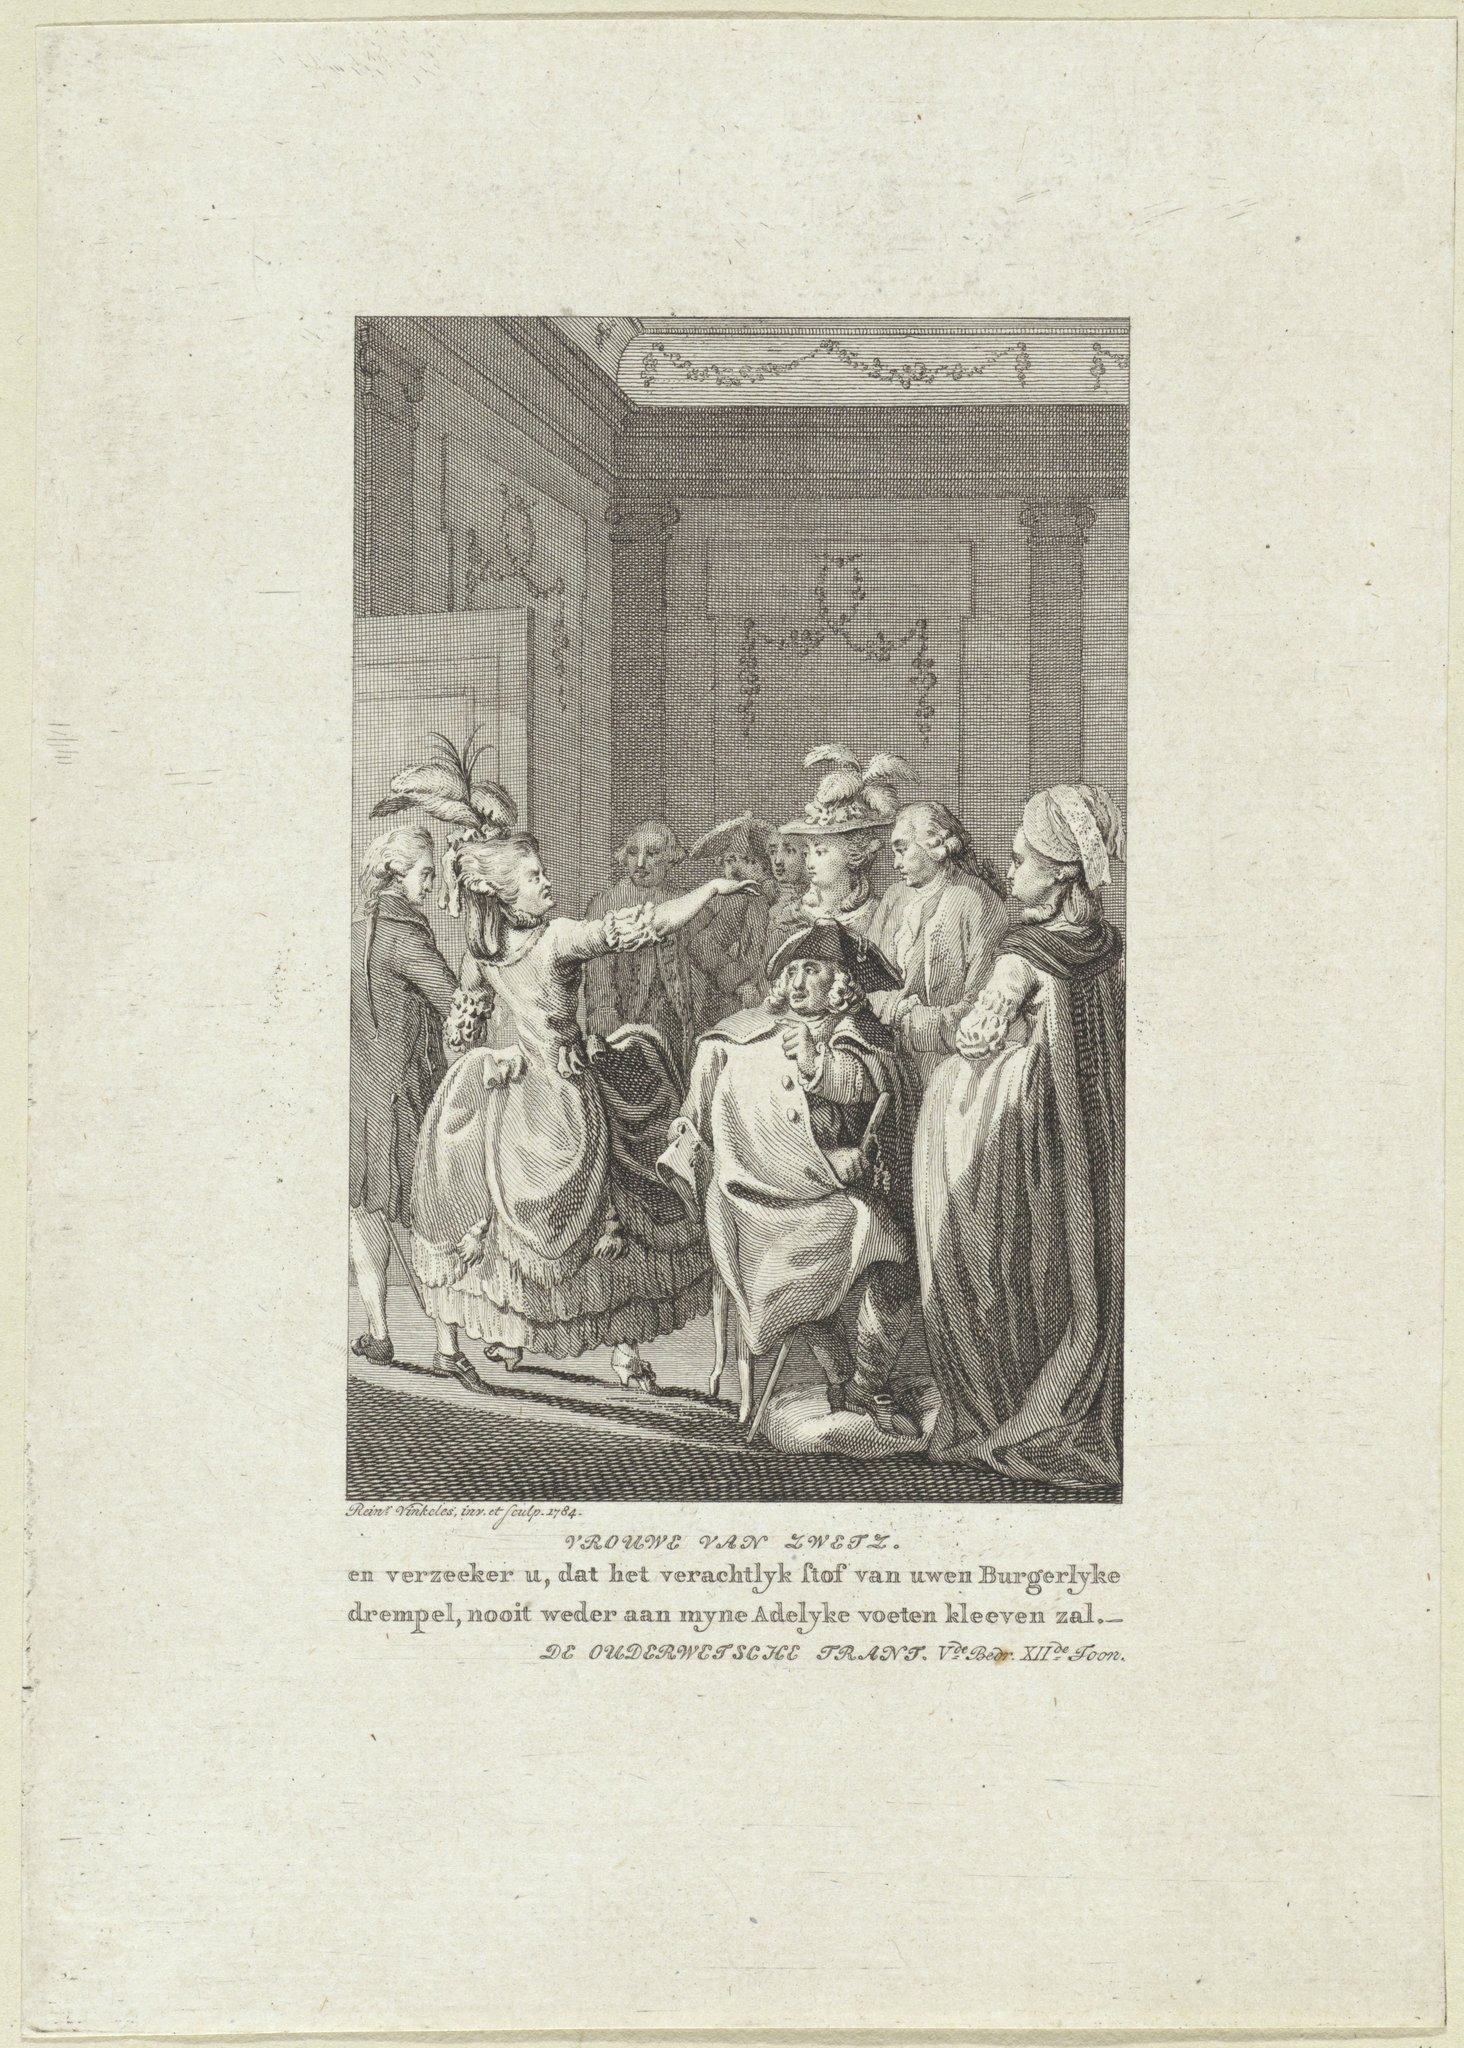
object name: print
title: Paar verlaat woedend een gezelschap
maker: reinier vinkeles (i)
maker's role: draughtsman, print maker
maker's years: 1741-1816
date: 1784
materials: paper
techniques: engraving, etching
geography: amsterdam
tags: vehemence, violence, fierceness; 'sforza con inganno', 'violenza' (ripa), pillow, aggressive relationships, enmity, animosity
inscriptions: collector's mark: Lugt 240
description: Deze prent is mogelijk gebruikt als illustratie in: De Ouderwetsche Trant. Amsterdam: Pieter Meĳer, 1784.